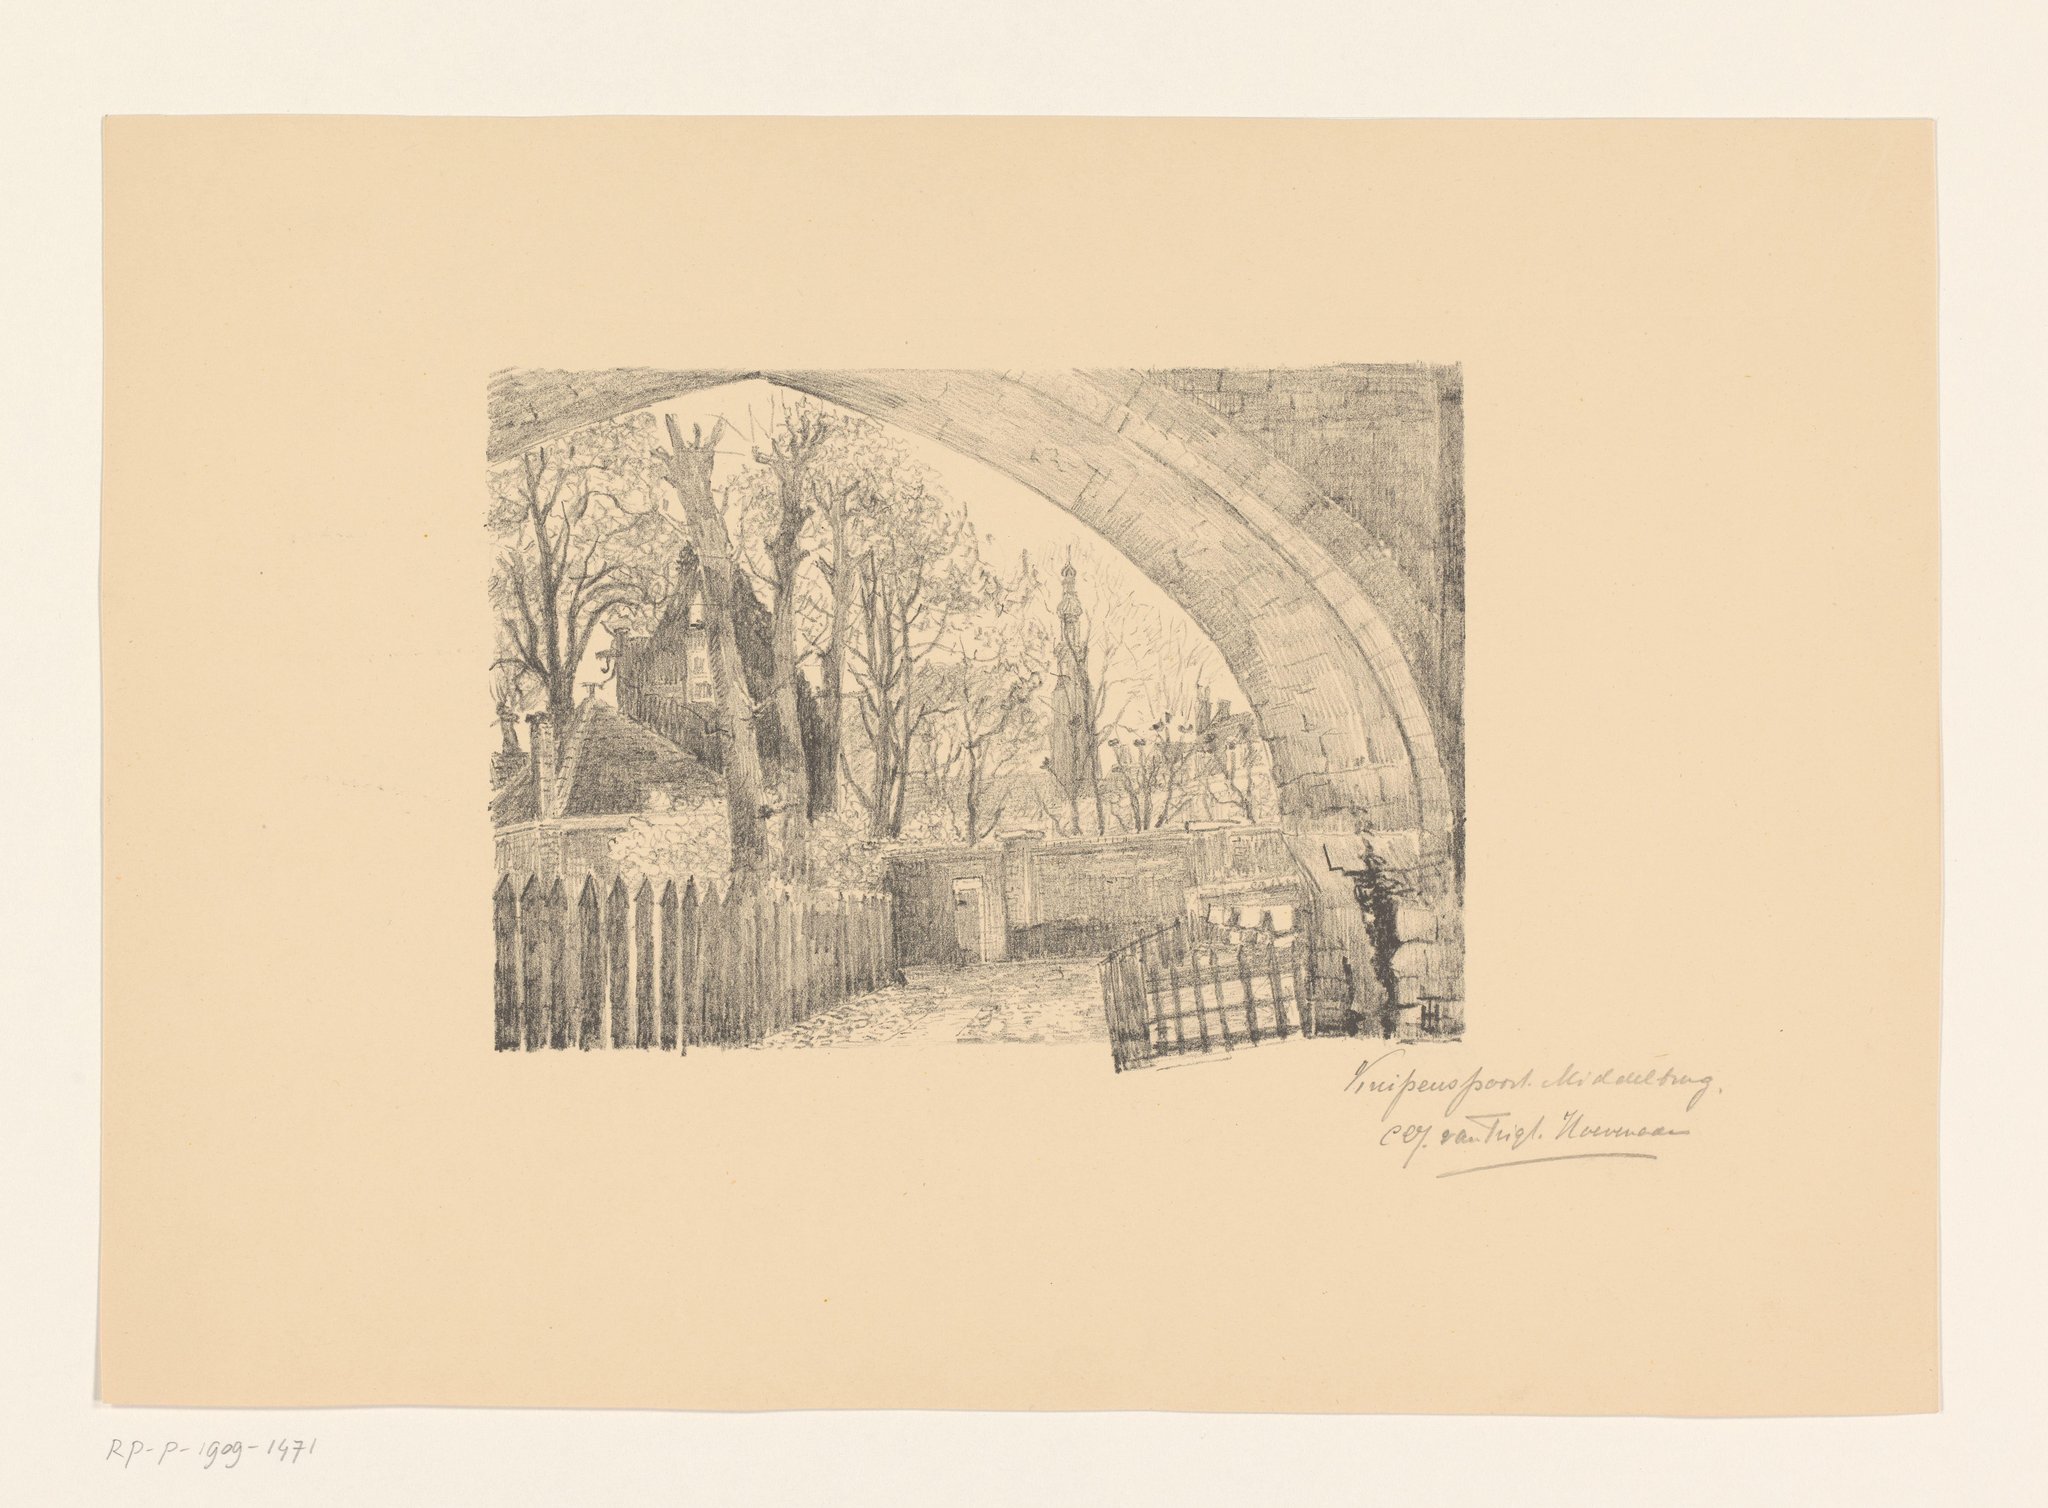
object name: print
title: Kuiperspoort in Middelburg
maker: cornelia christina johanna van trigt-hoevenaar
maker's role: print maker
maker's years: 1854-1924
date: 1864-1909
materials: paper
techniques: lithograph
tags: parts of church exterior and annexes: tower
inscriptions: collector's mark: Lugt 2228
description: Op de achtergrond de Abdijtoren (de Lange Jan).